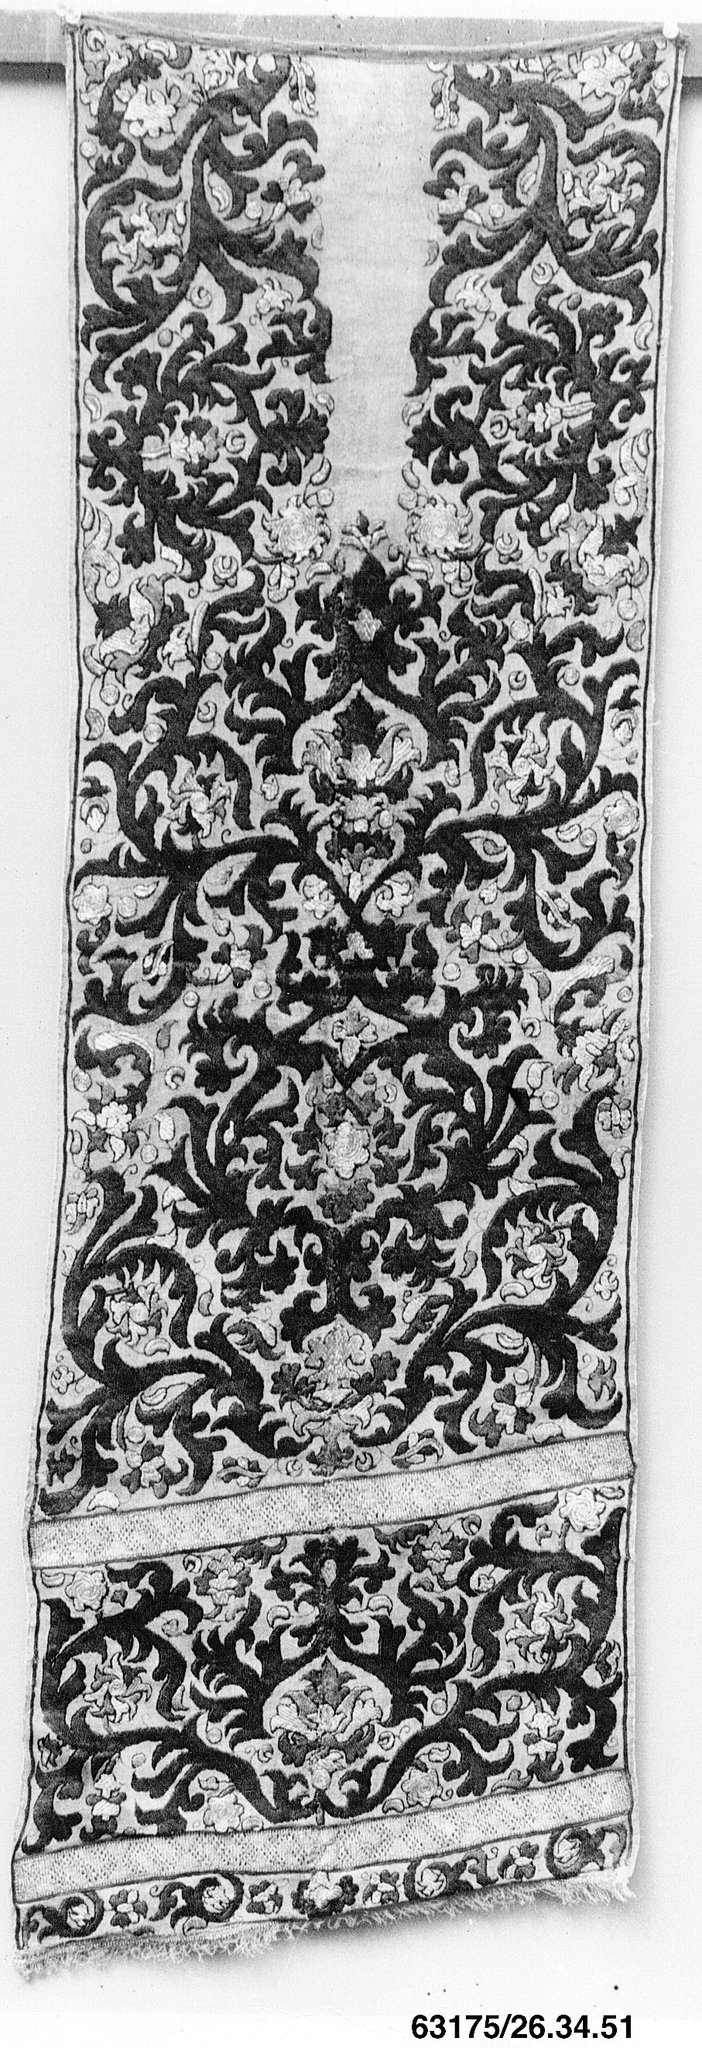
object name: scarf end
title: Scarf End (Tenchifa)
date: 1701-1800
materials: linen, silk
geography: algeria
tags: flowers